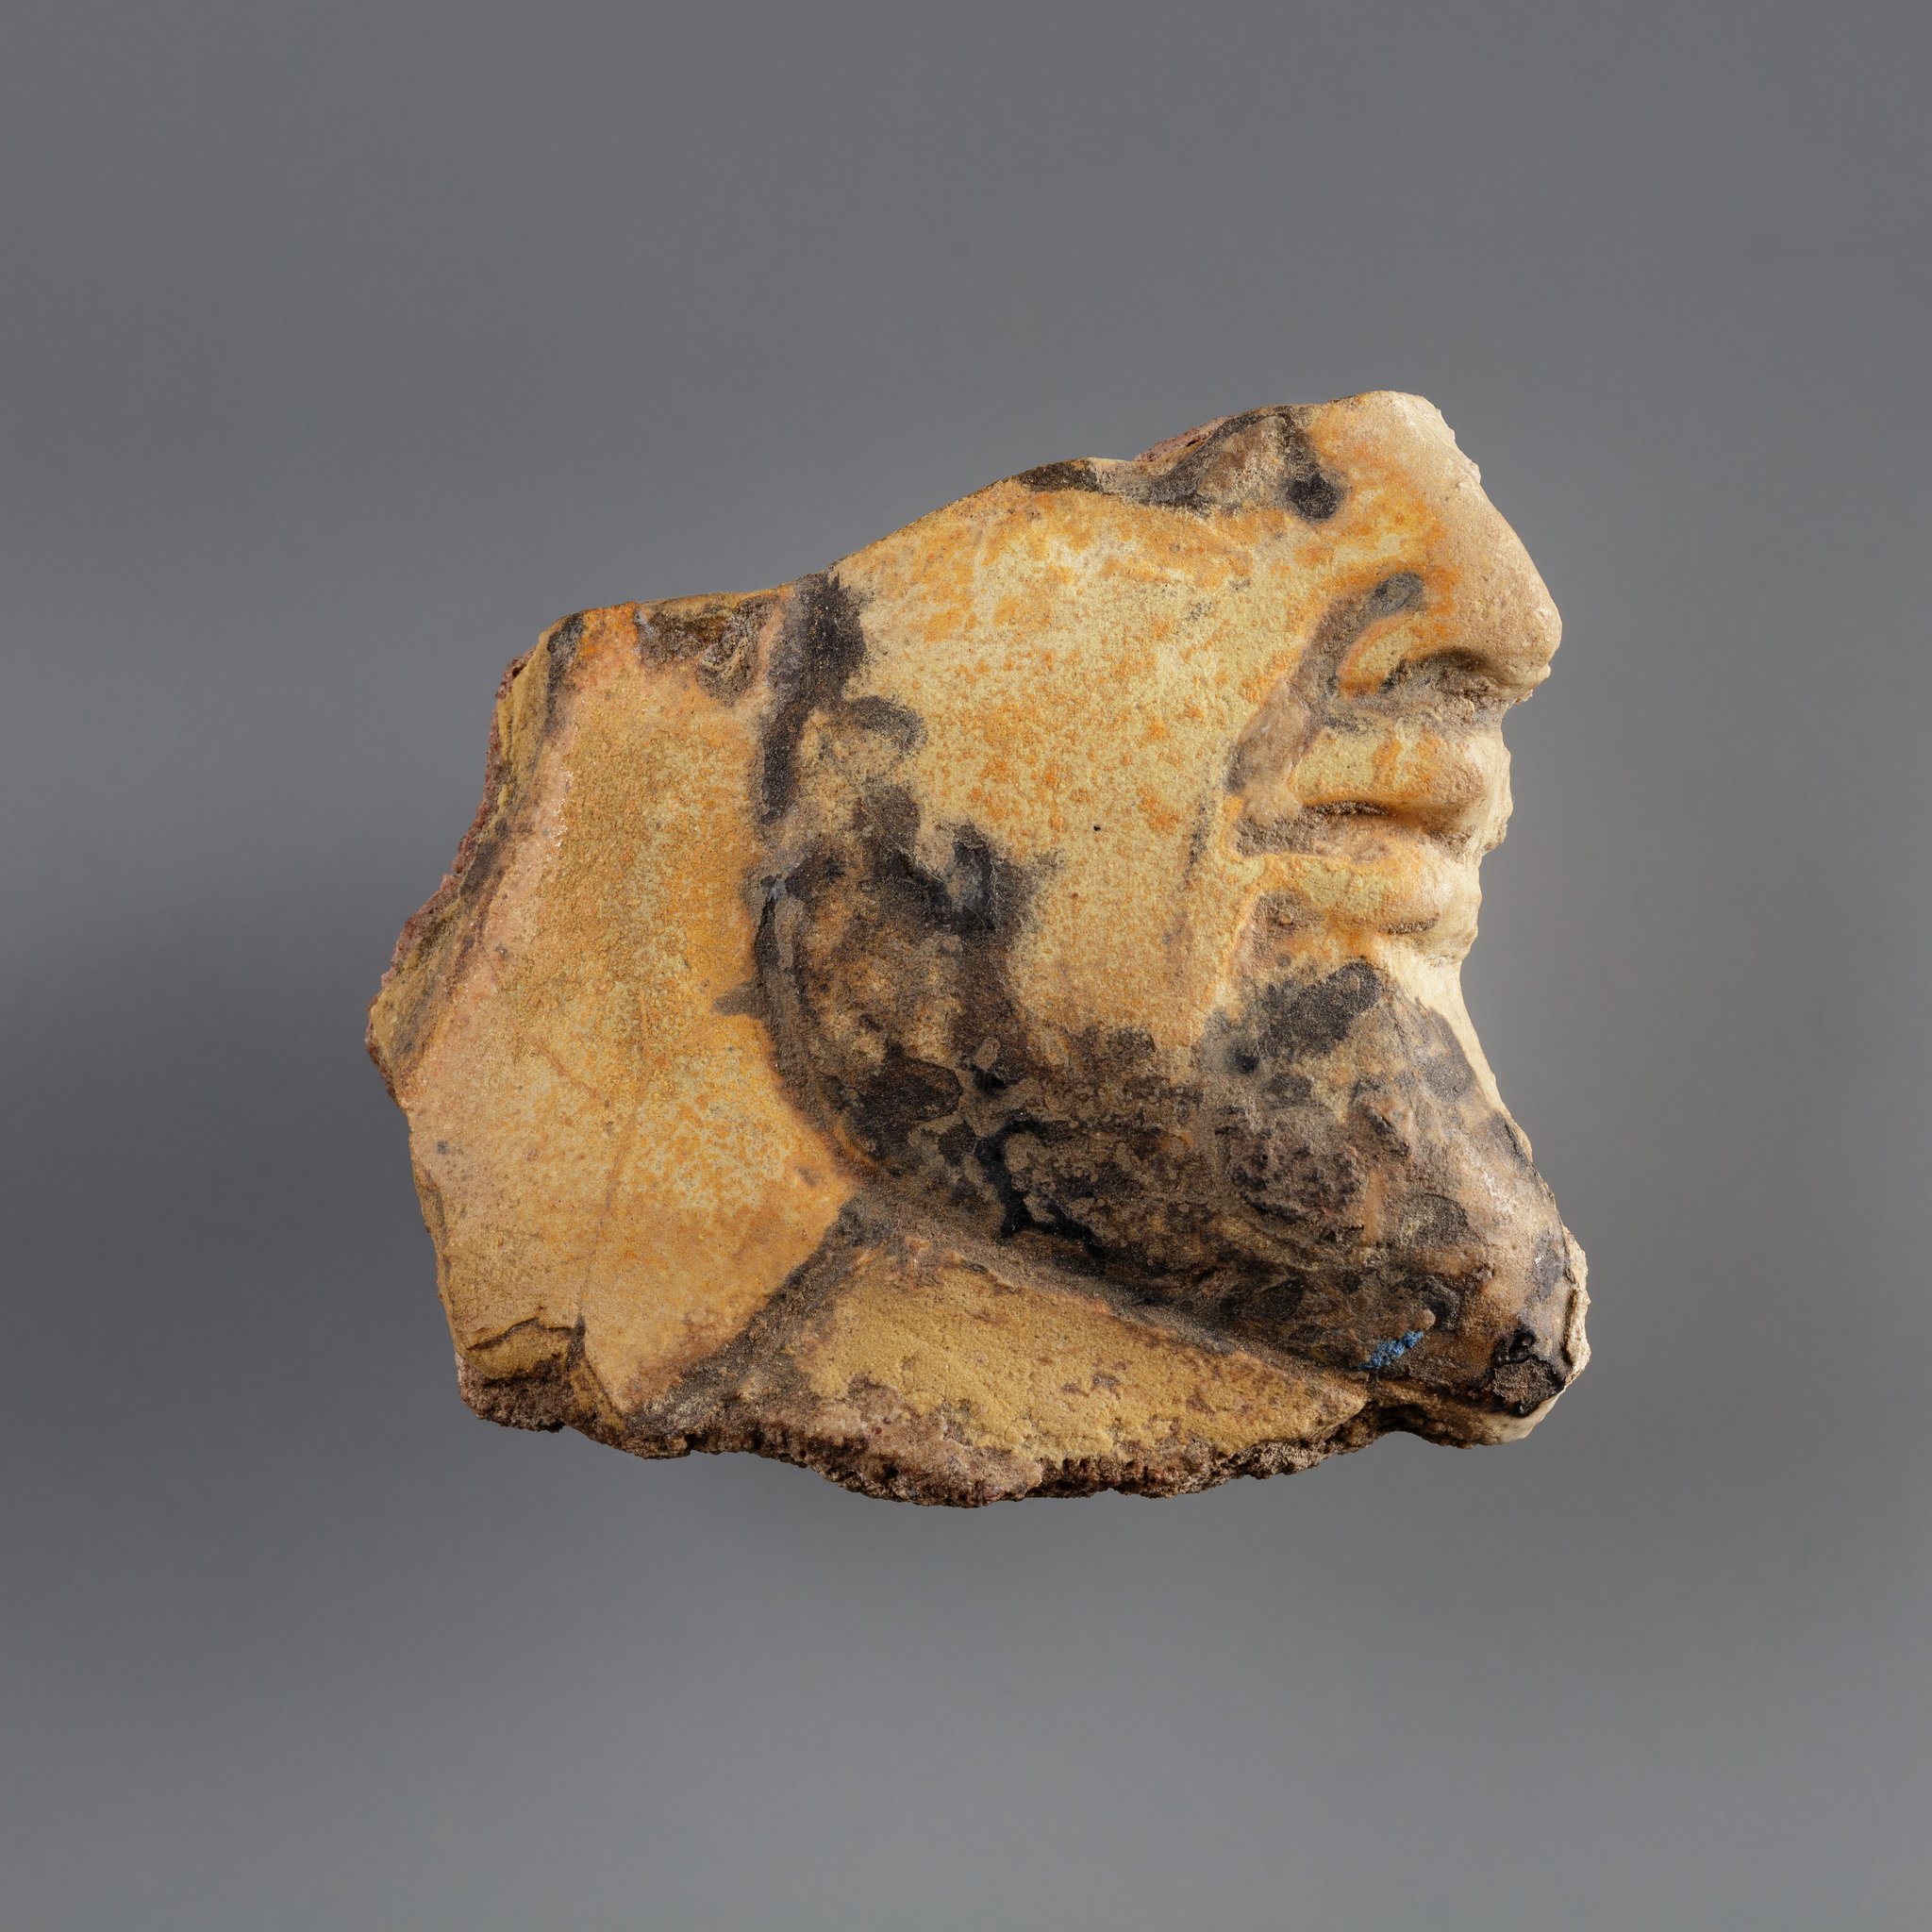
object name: tile, palace of ramesses ii, bearded face, mesopotamian singer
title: Tile with a head of a Mesopotamian captive from the palace of Ramesses II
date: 1279-1213 BCE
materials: faience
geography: egypt